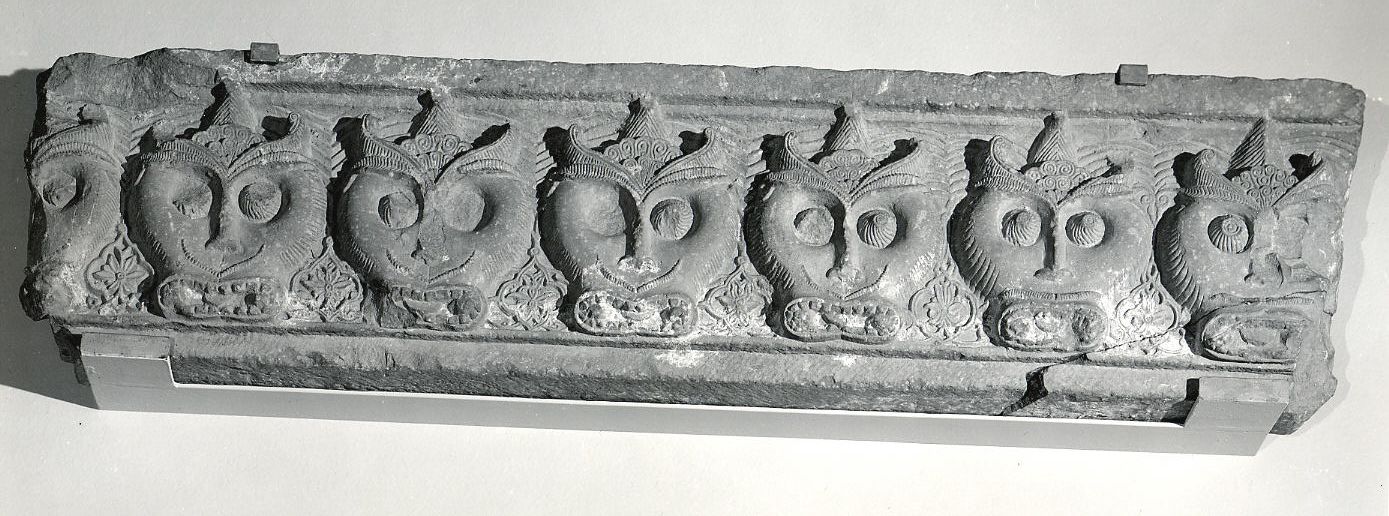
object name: fragment of a cornice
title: Fragment of a Cornice with a Frieze of Masks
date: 1401-1533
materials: stone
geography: india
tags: masks